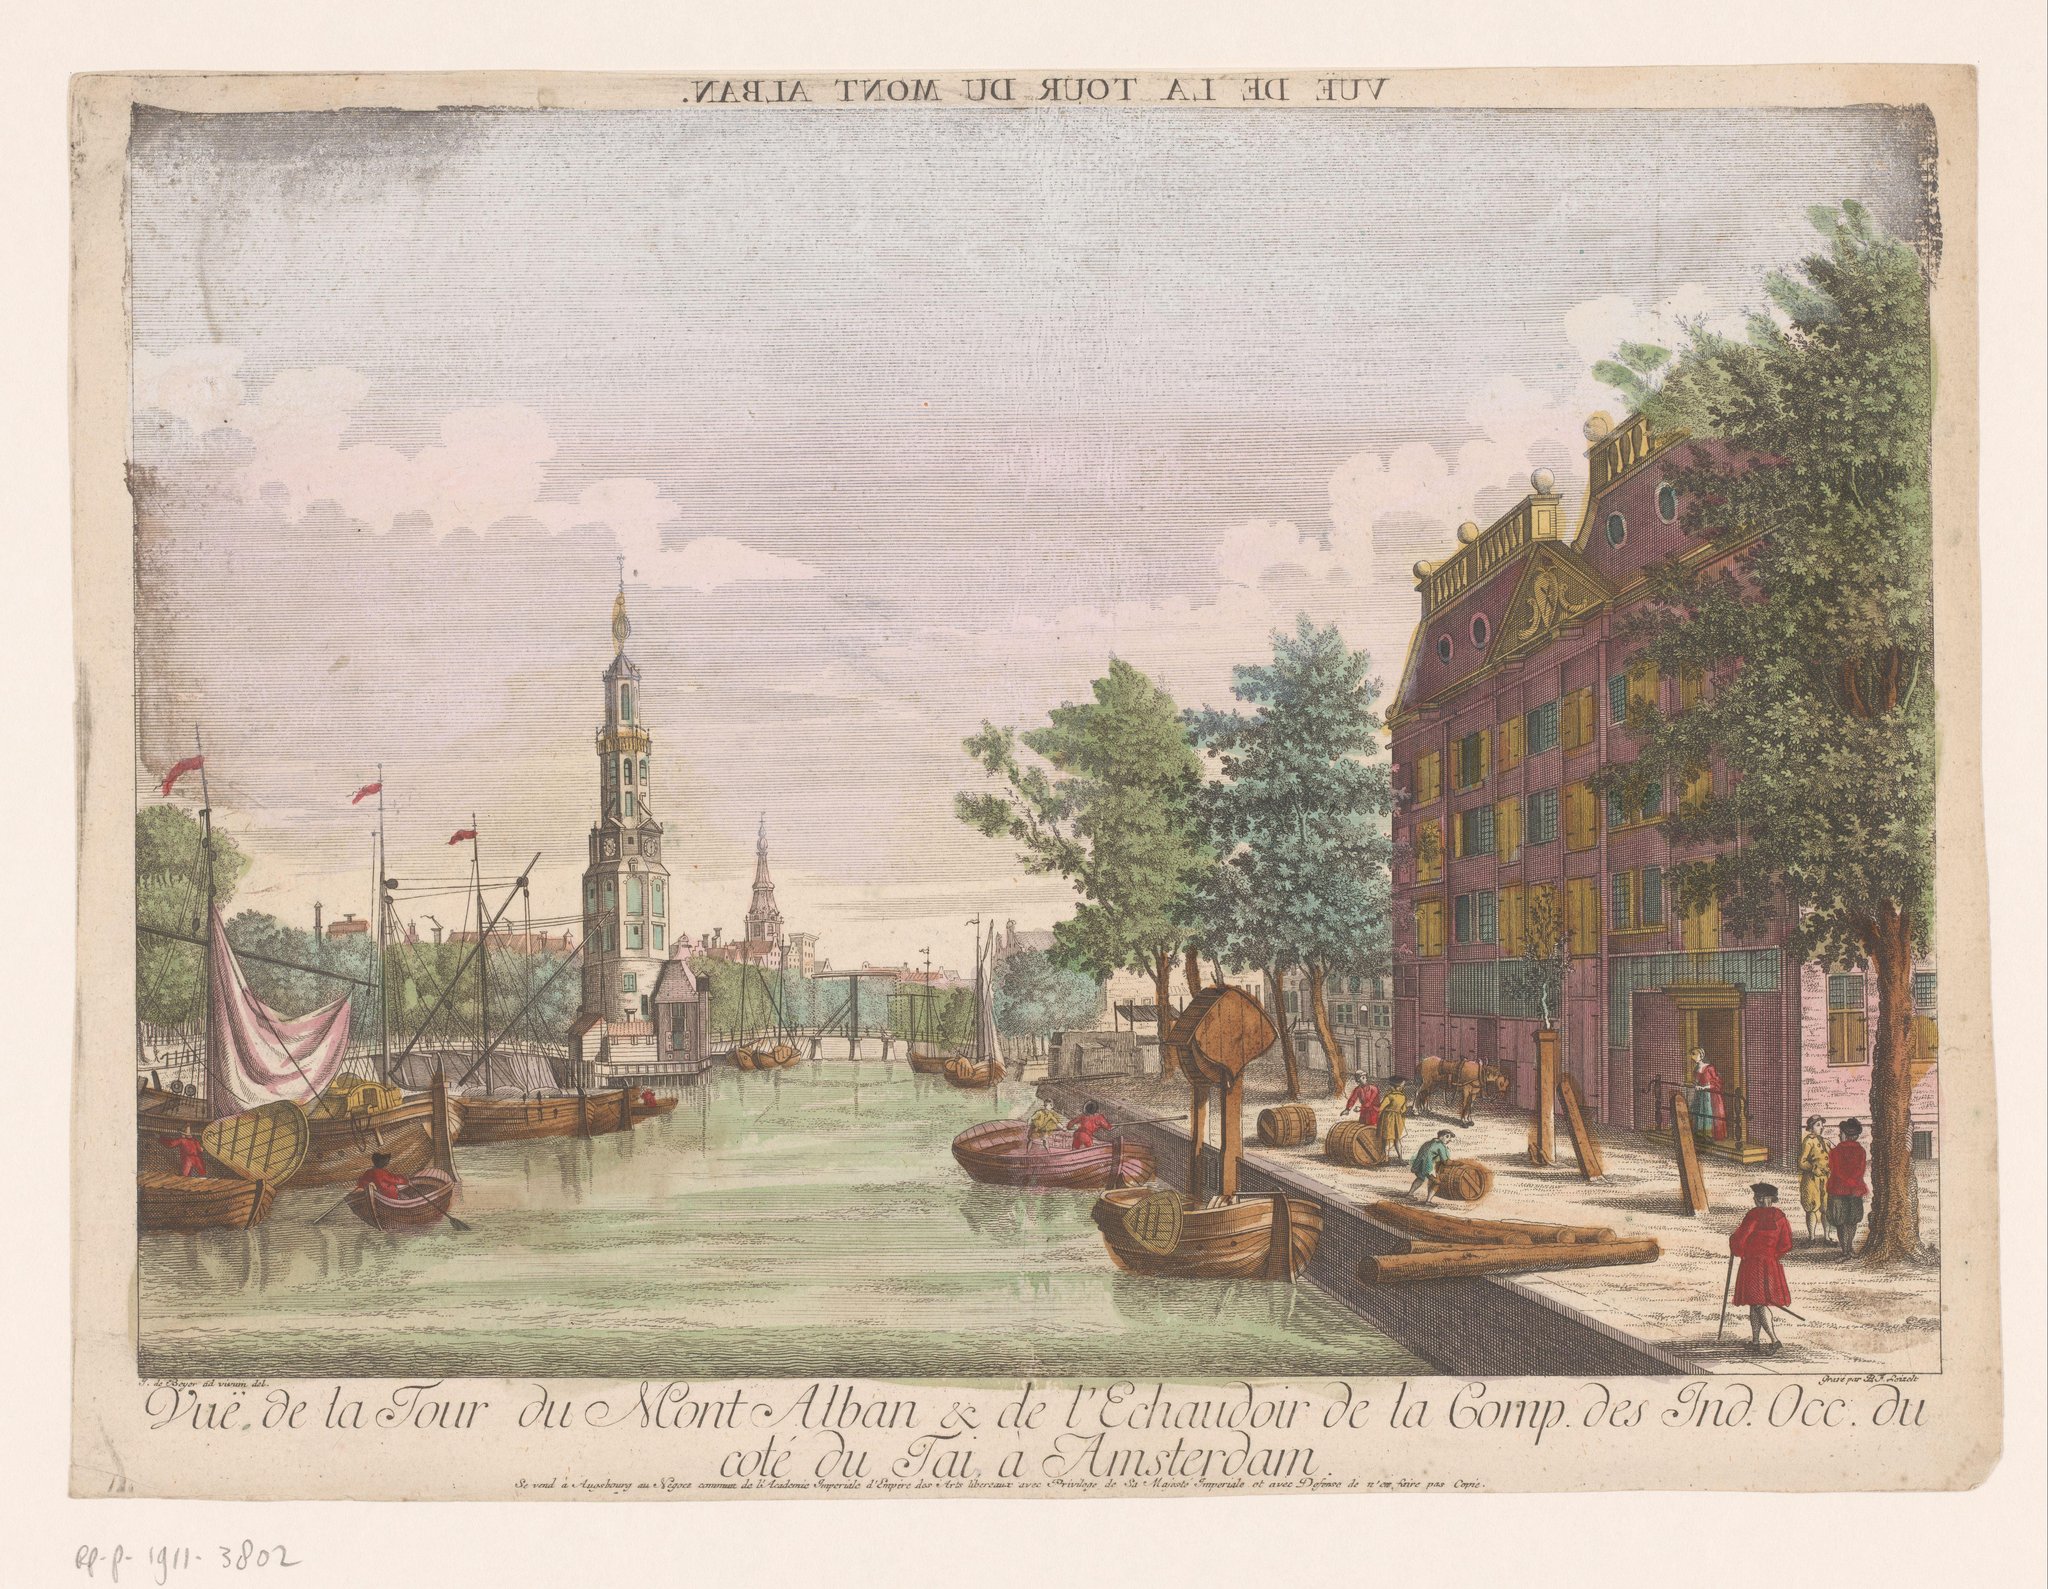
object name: opticaprent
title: Vuë de la Tour du Mont Alban (...)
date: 1755-1779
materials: paper, watercolor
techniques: brush, etching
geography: augsburg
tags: bridge in city across river, canal, etc. (+ city(-scape) with figures, staffage), tower, clock tower ~ monumental adornment, city-view in general; 'veduta', canal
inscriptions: collector's mark: Lugt 2228